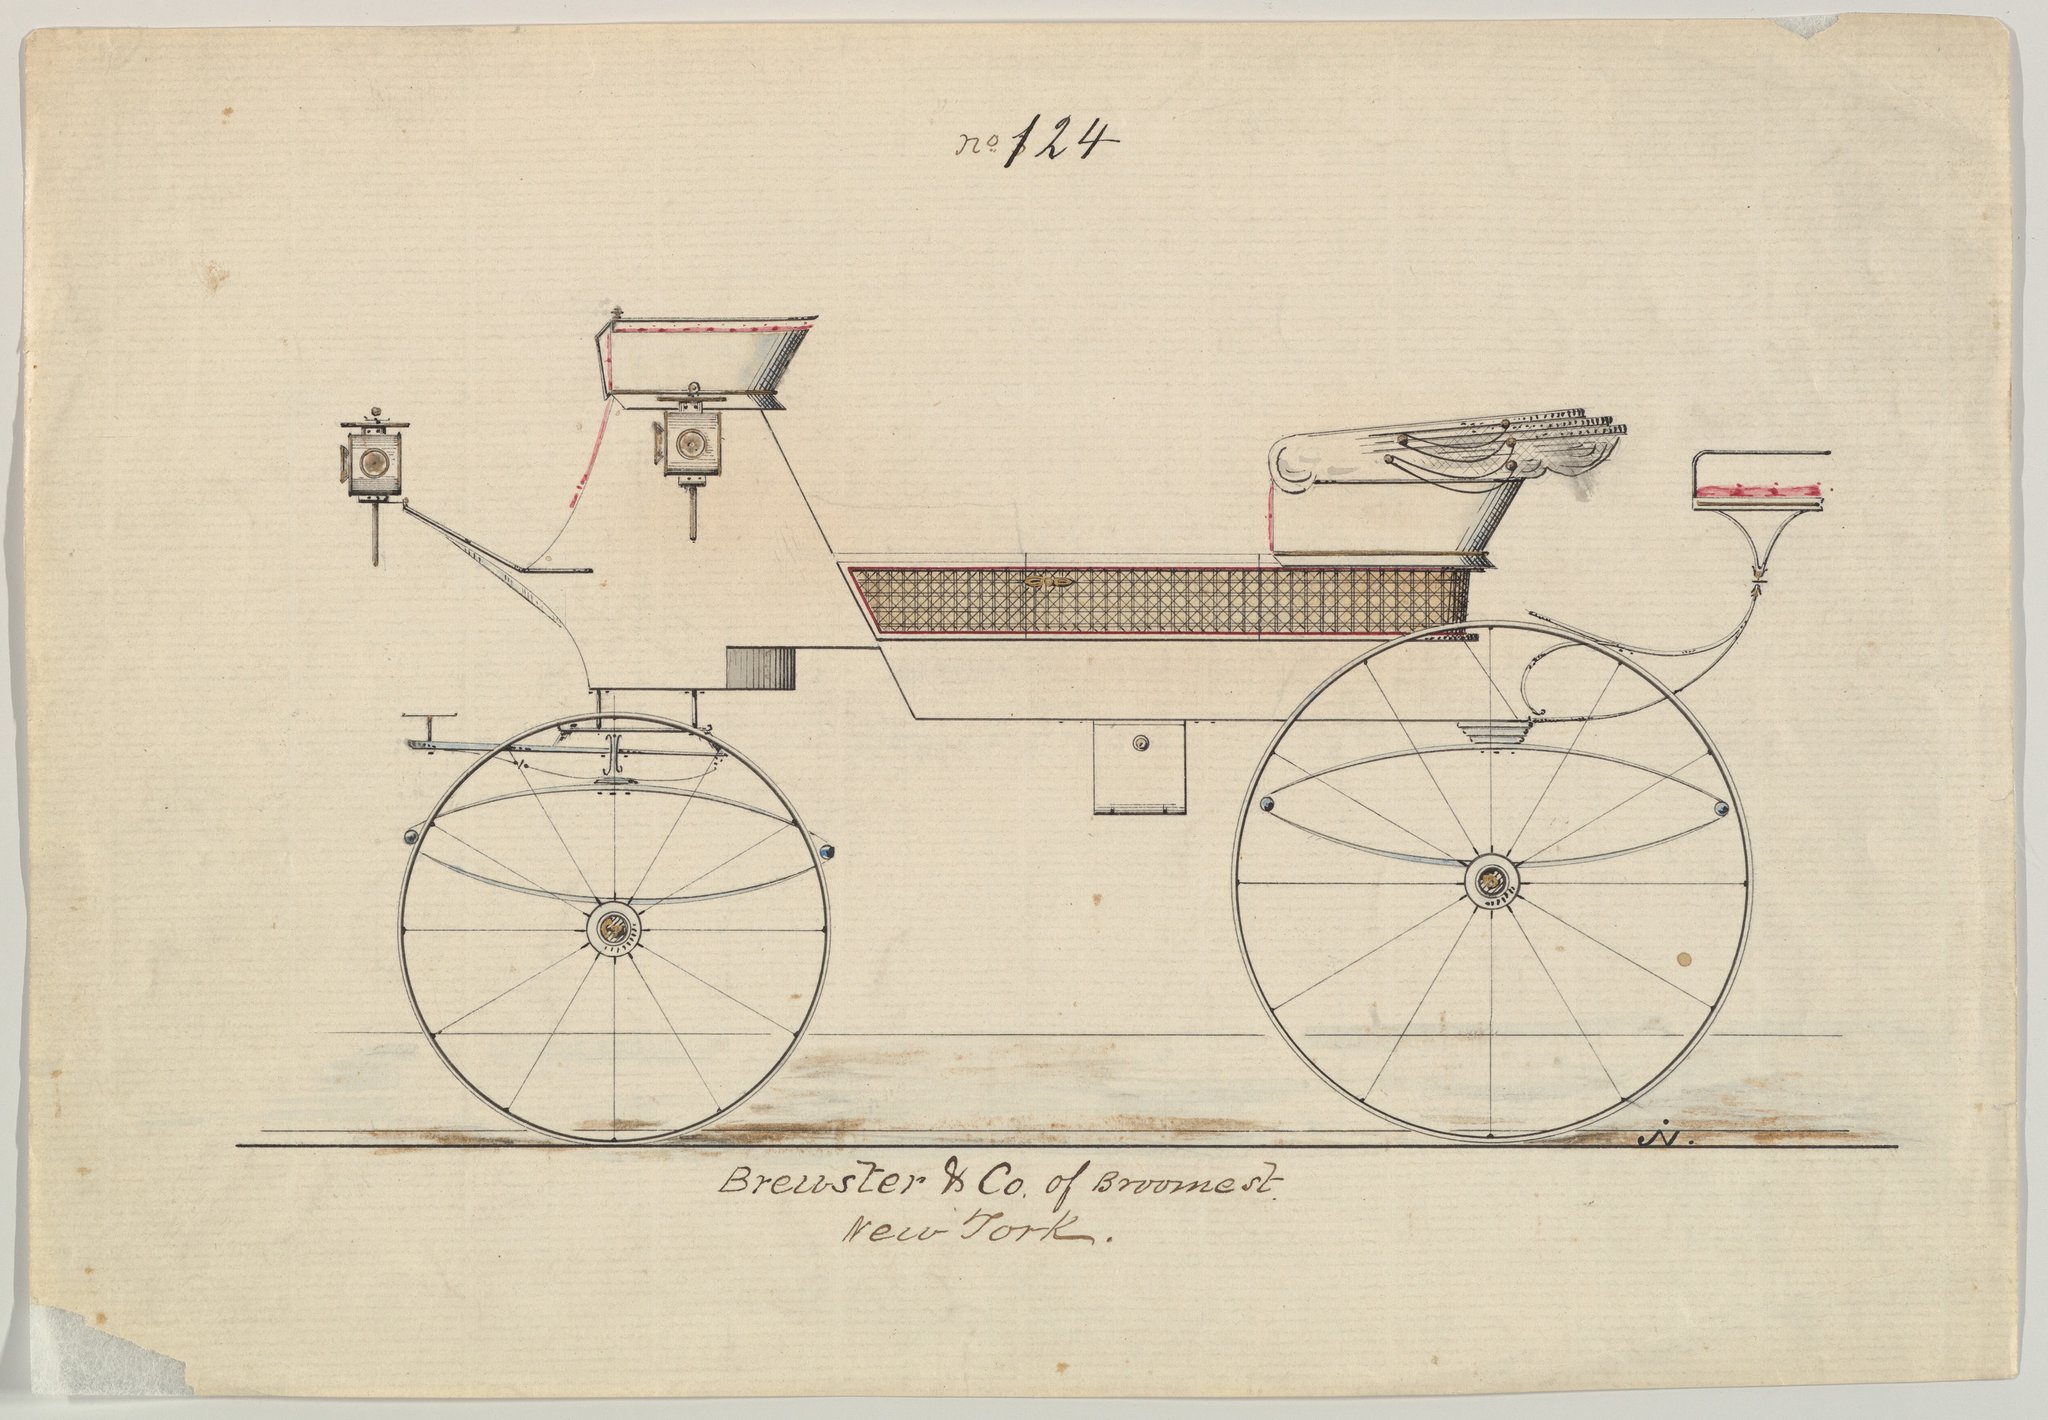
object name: drawing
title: Drag #124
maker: brewster & co.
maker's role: manufacturer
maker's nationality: american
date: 1860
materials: gouache, ink, watercolor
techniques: pen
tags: carriages